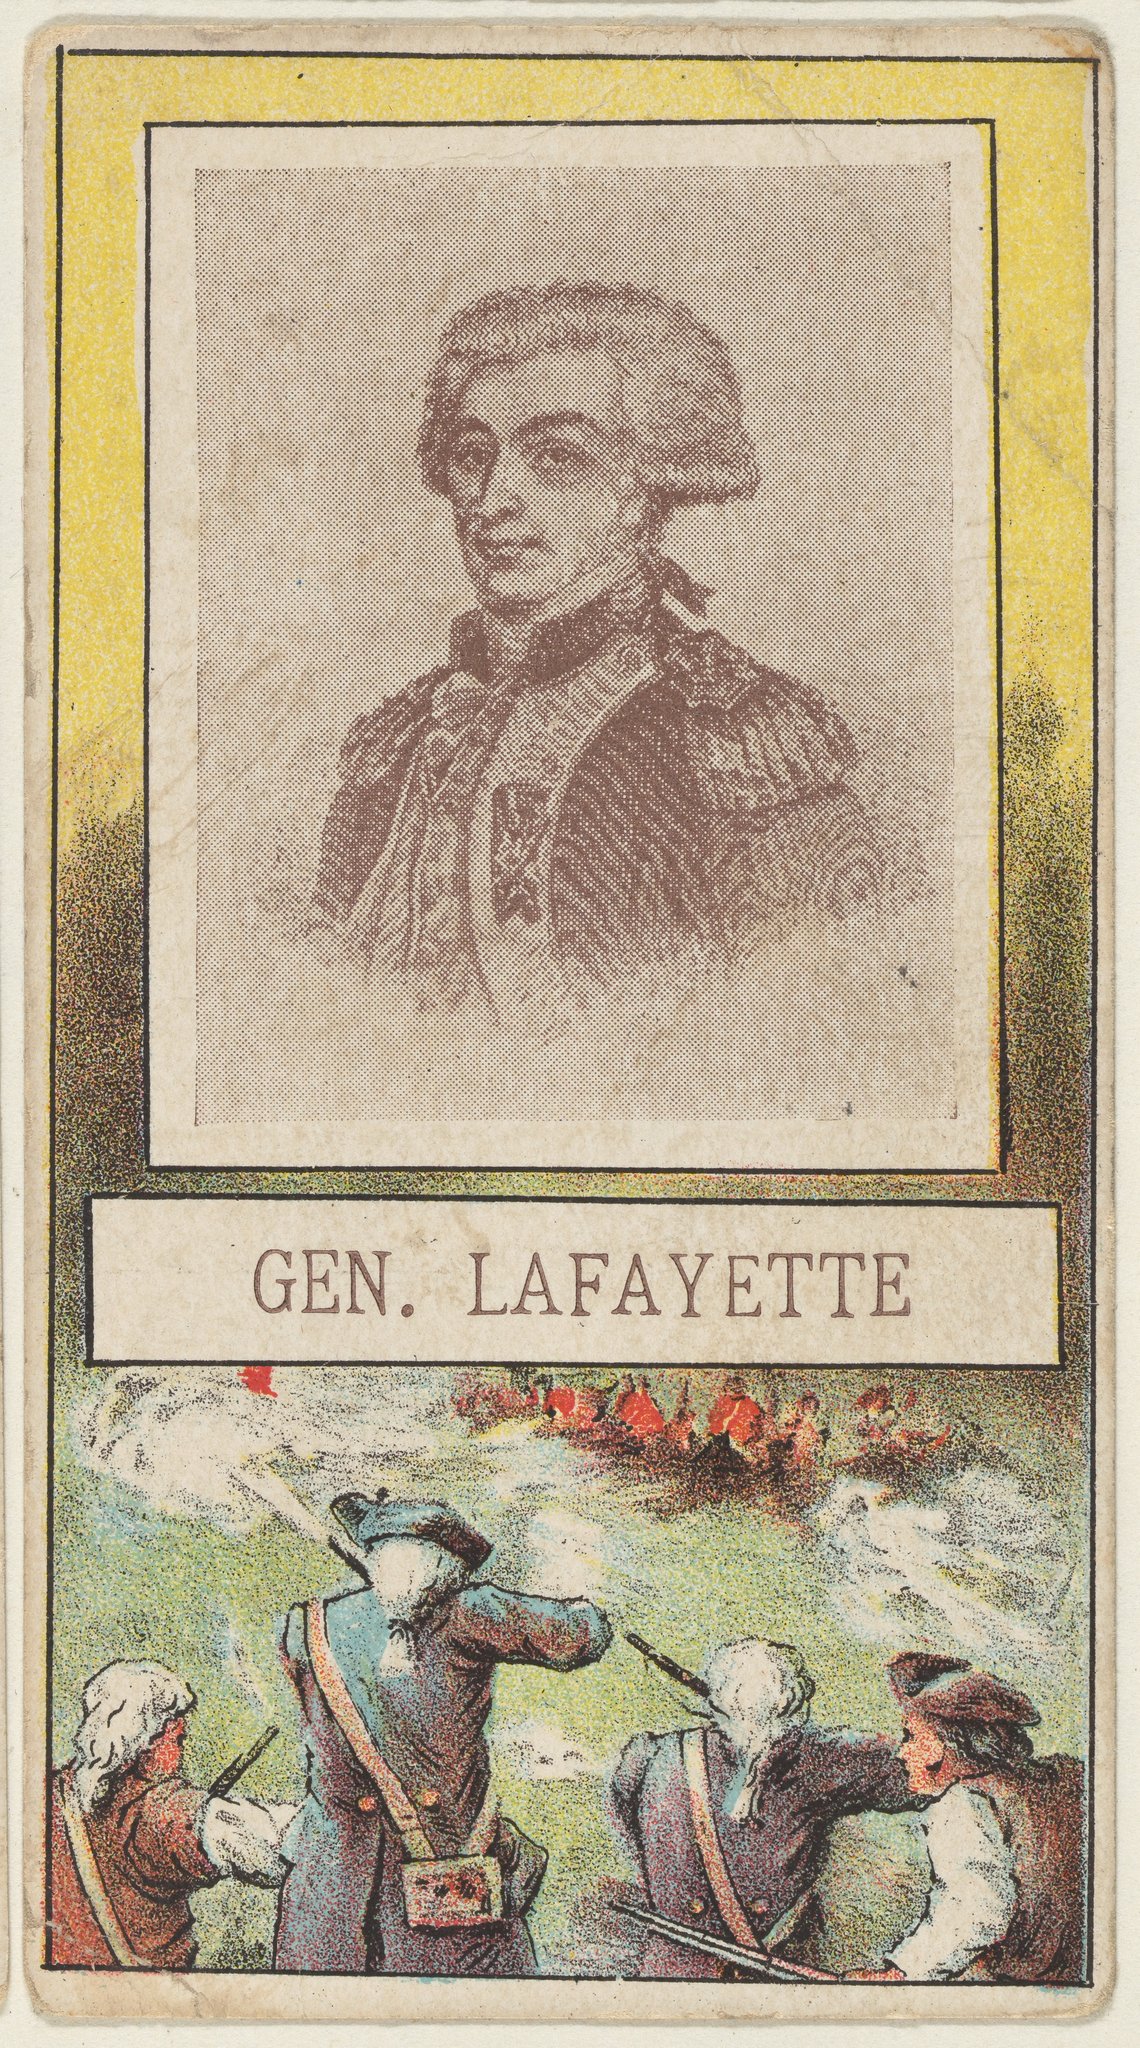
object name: print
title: General Lafayette, from the "Generals" series (T64), issued by D.H. McAlpin & Co. Tobacco Company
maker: d.h. mcalpin & co. tobacco company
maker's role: publisher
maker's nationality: american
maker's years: 1857-1901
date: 1901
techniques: color lithograph